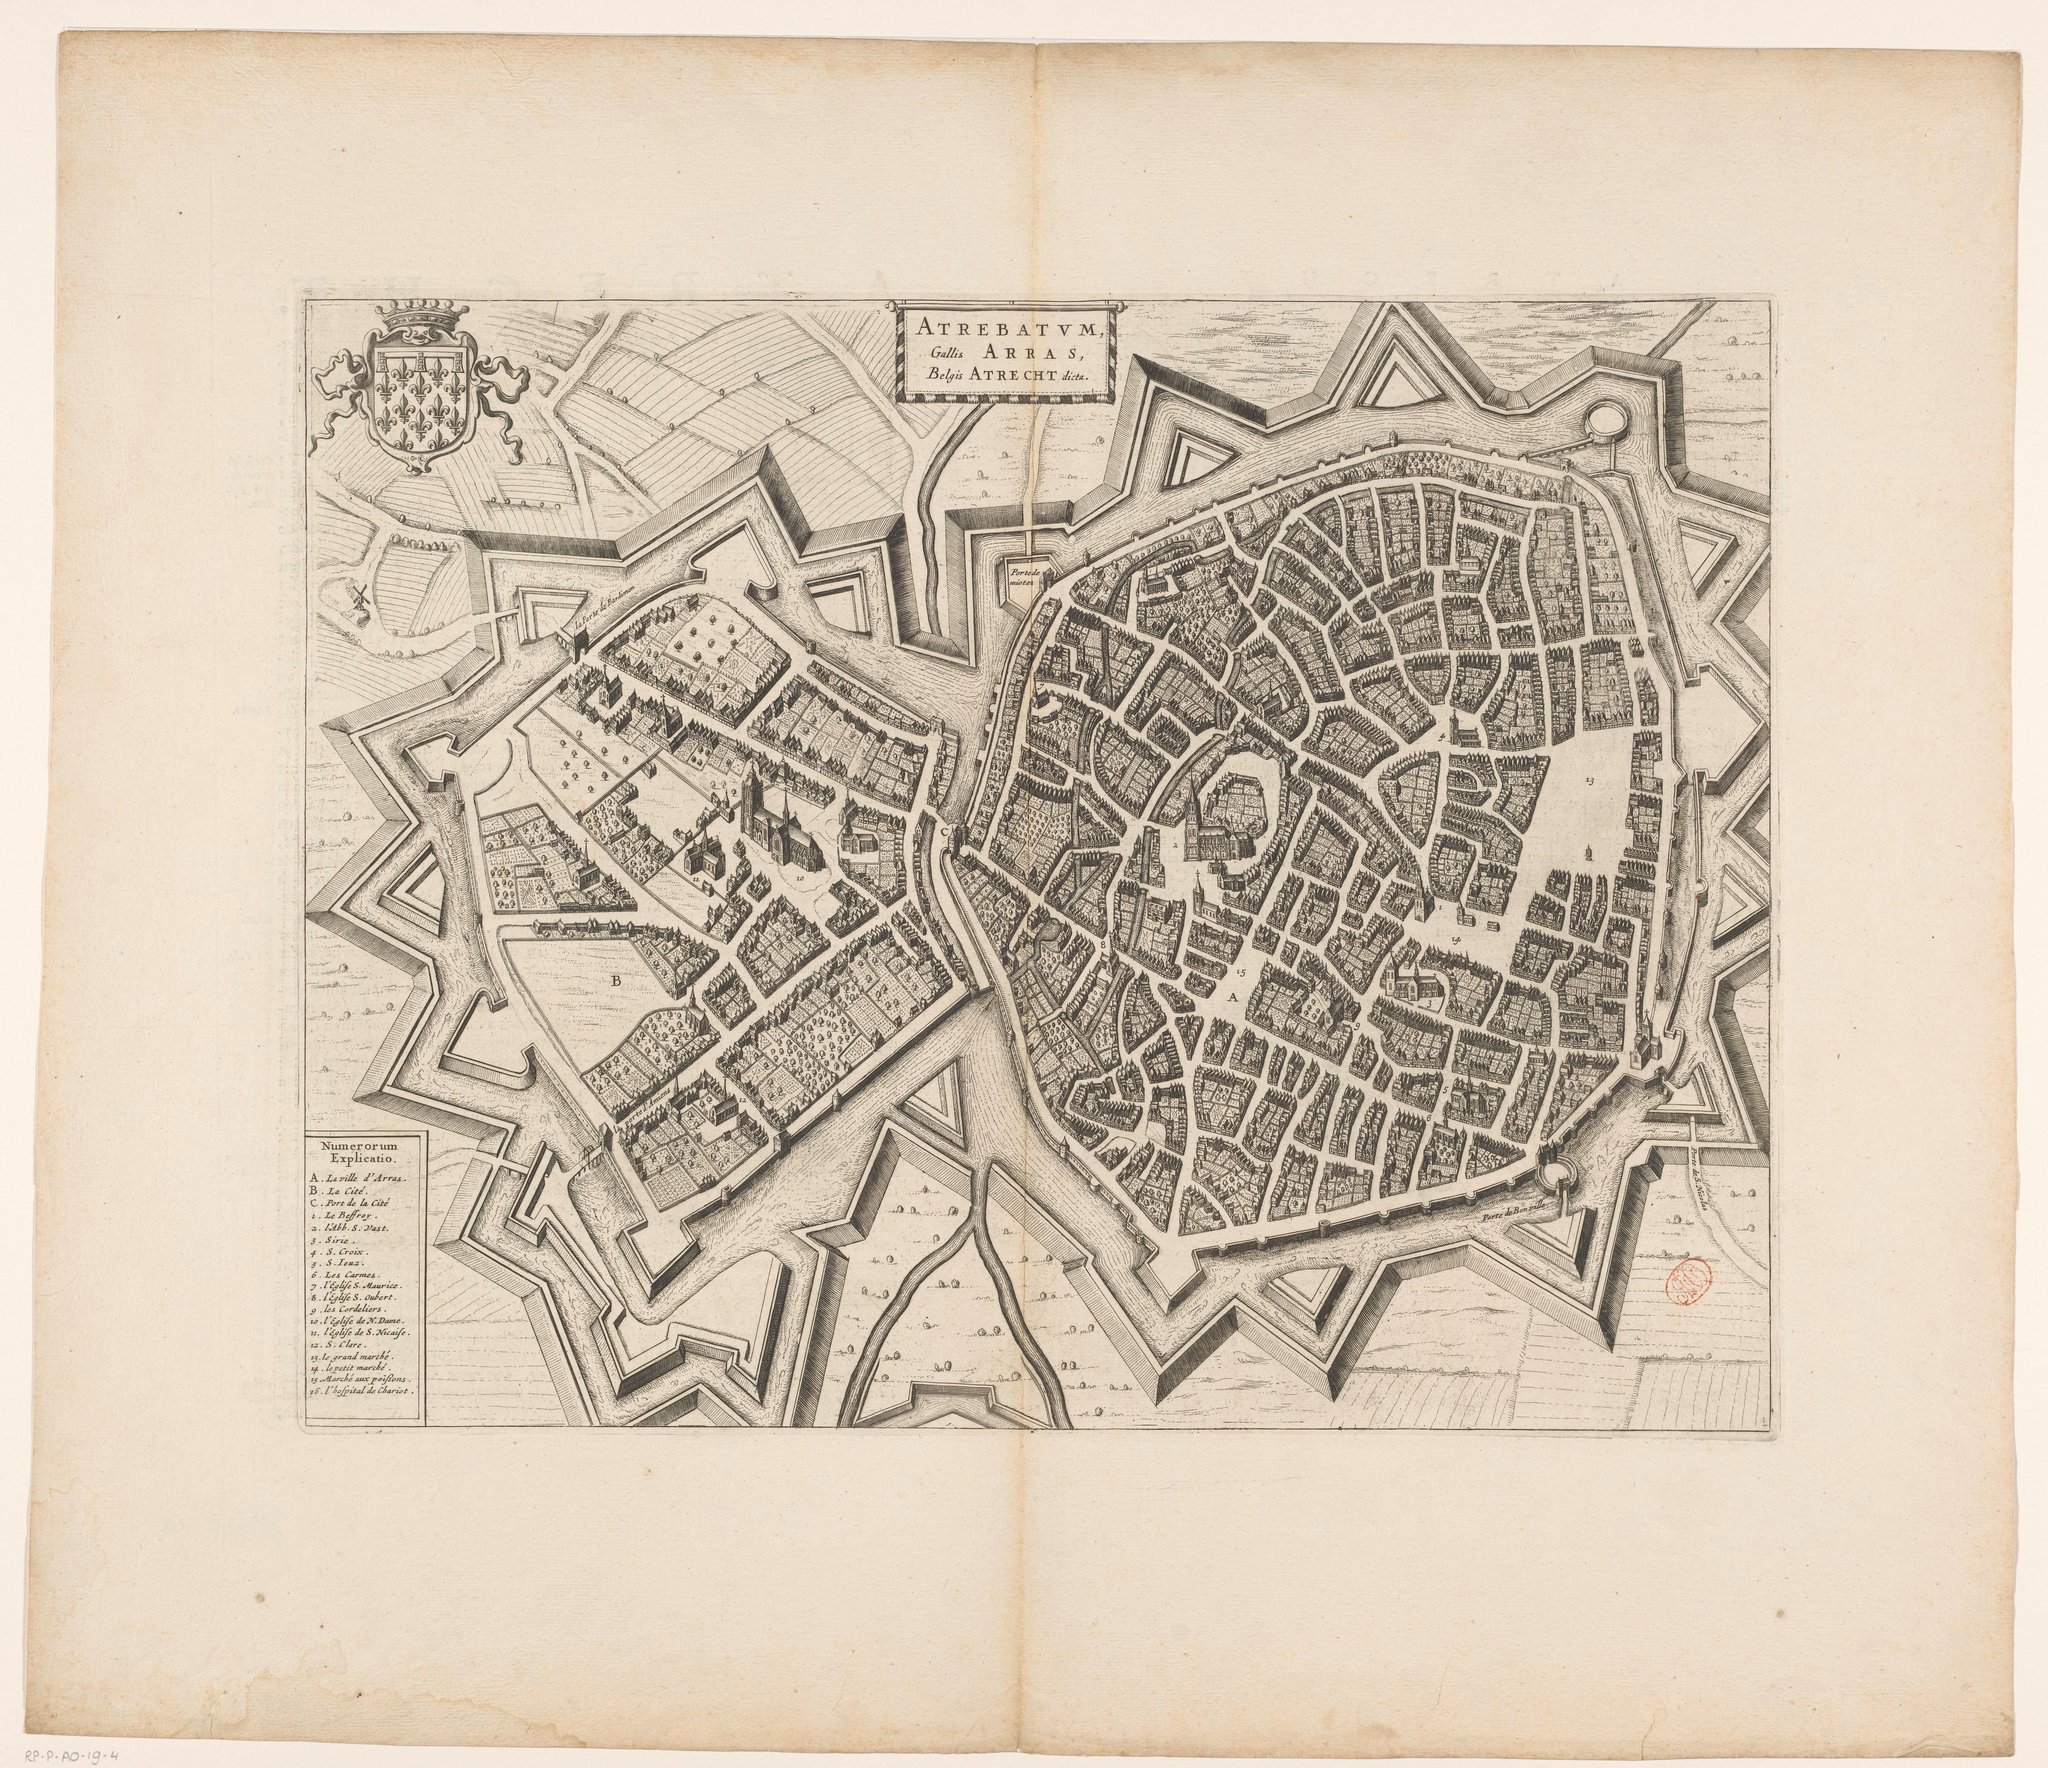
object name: area plan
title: Atrebatum, Gallis Arras, Belgis Atrecht dicta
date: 1652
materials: paper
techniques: engraving, etching, letterpress printing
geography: amsterdam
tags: fortified city, maps of cities, coat of arms (as symbol of the state, etc.) (+ province; provincial)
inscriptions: collector's mark: Lugt 195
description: Plattegrond van Arras (Atrecht) met gebouwen in vogelvluchtperspectief. Boven, in het midden, een kader met titel. Linksonder een kader met legenda 1-16. Linksboven het wapen van het graafschap Artesië. Met Nederlandse tekst op verso.